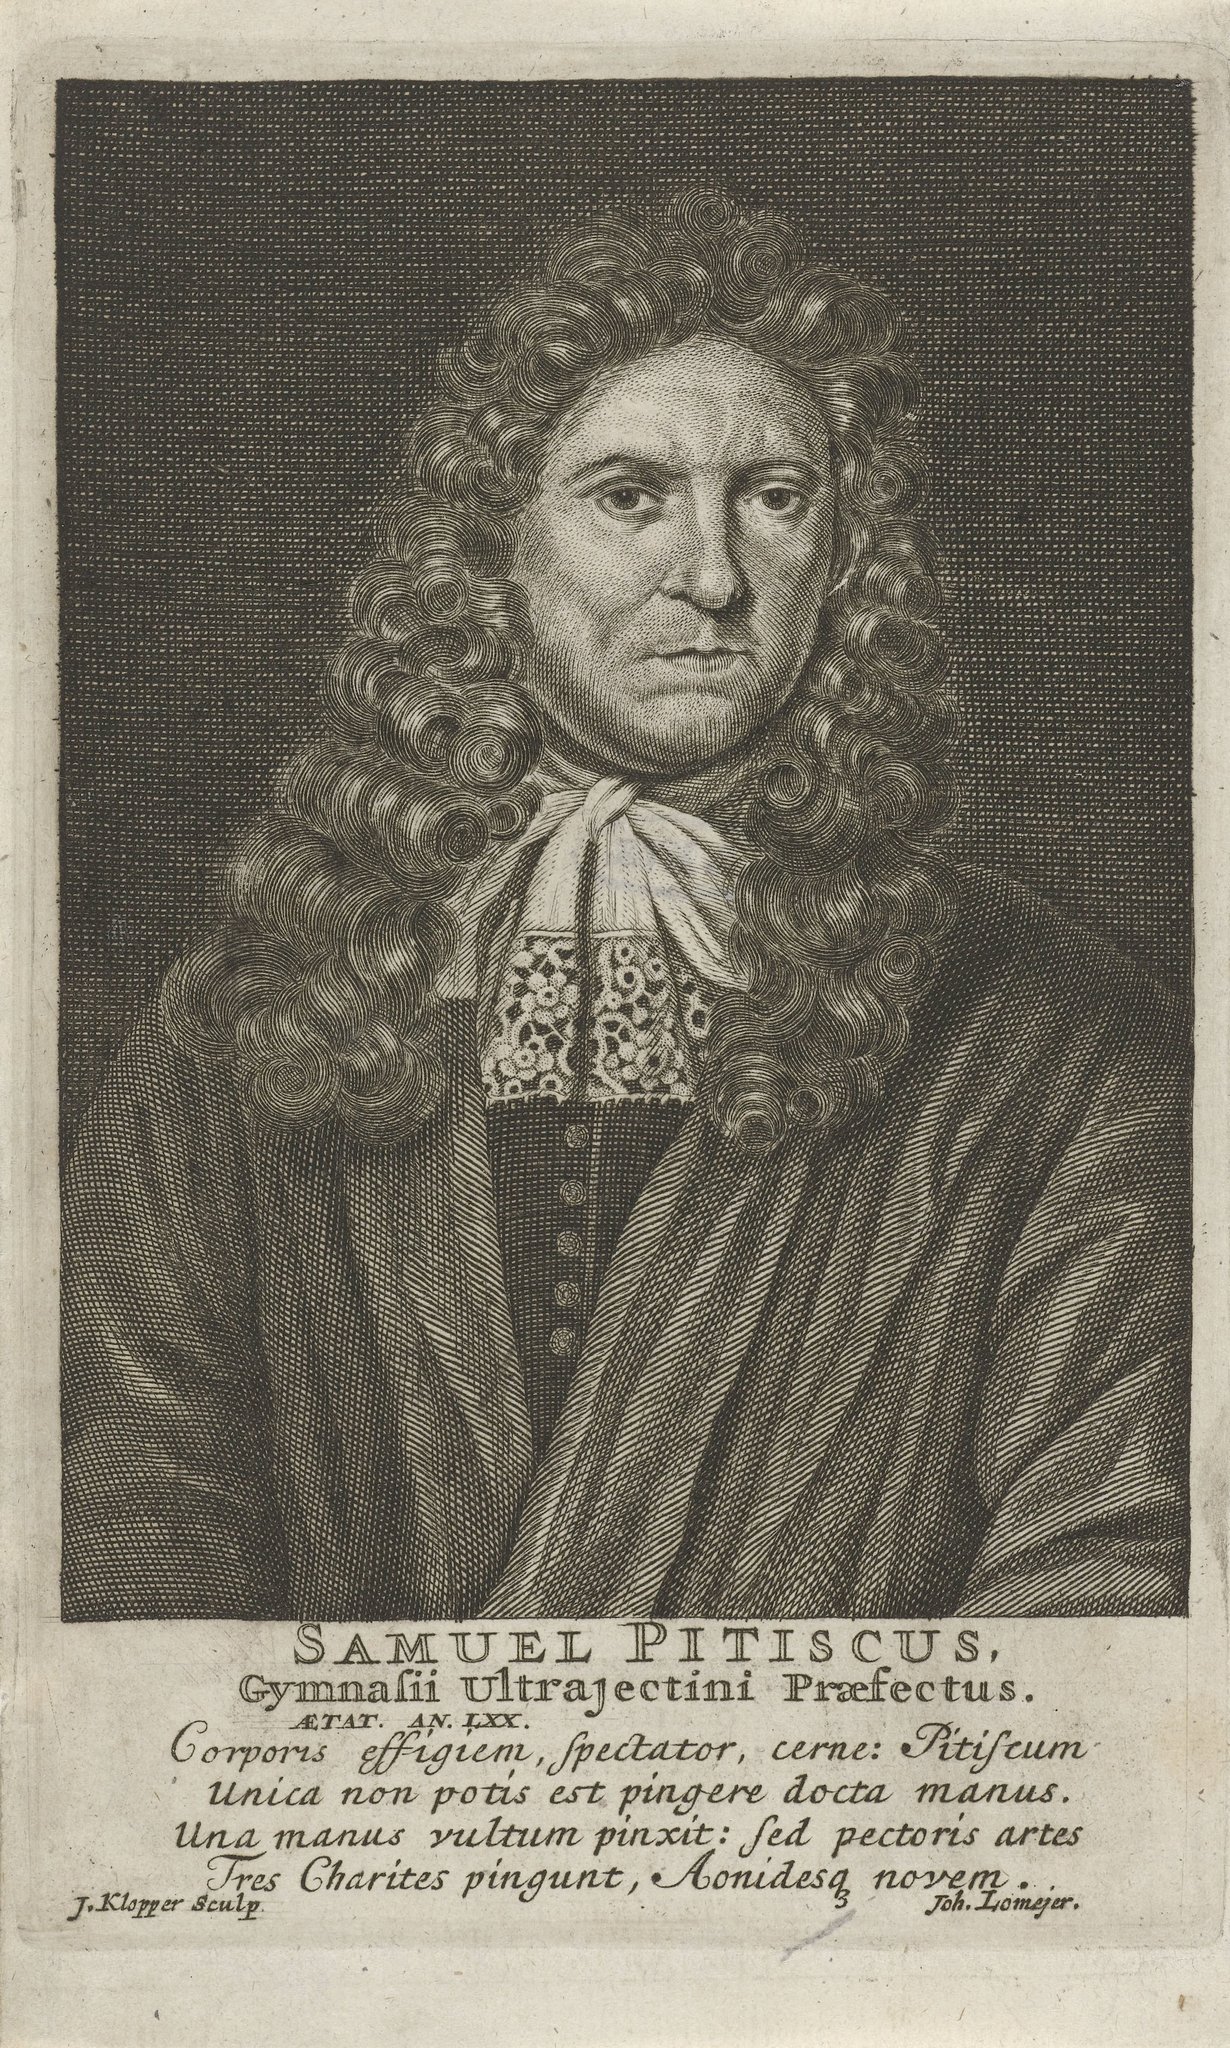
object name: print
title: Samuel Pitiscus, Gymnasii Ultrajectini Preafectus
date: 1707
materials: paper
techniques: engraving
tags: samuel pitiscus, historical persons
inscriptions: collector's mark: Lugt 2228, collector's mark: Lugt 2760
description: Portret ten halven lijve van de zeventigjarige rector en schrijver Samuel Pitiscus. Hij draagt een lange pruik en een geborduurde das. Onder de afbeelding een vierregelige tekst in het Latijn.